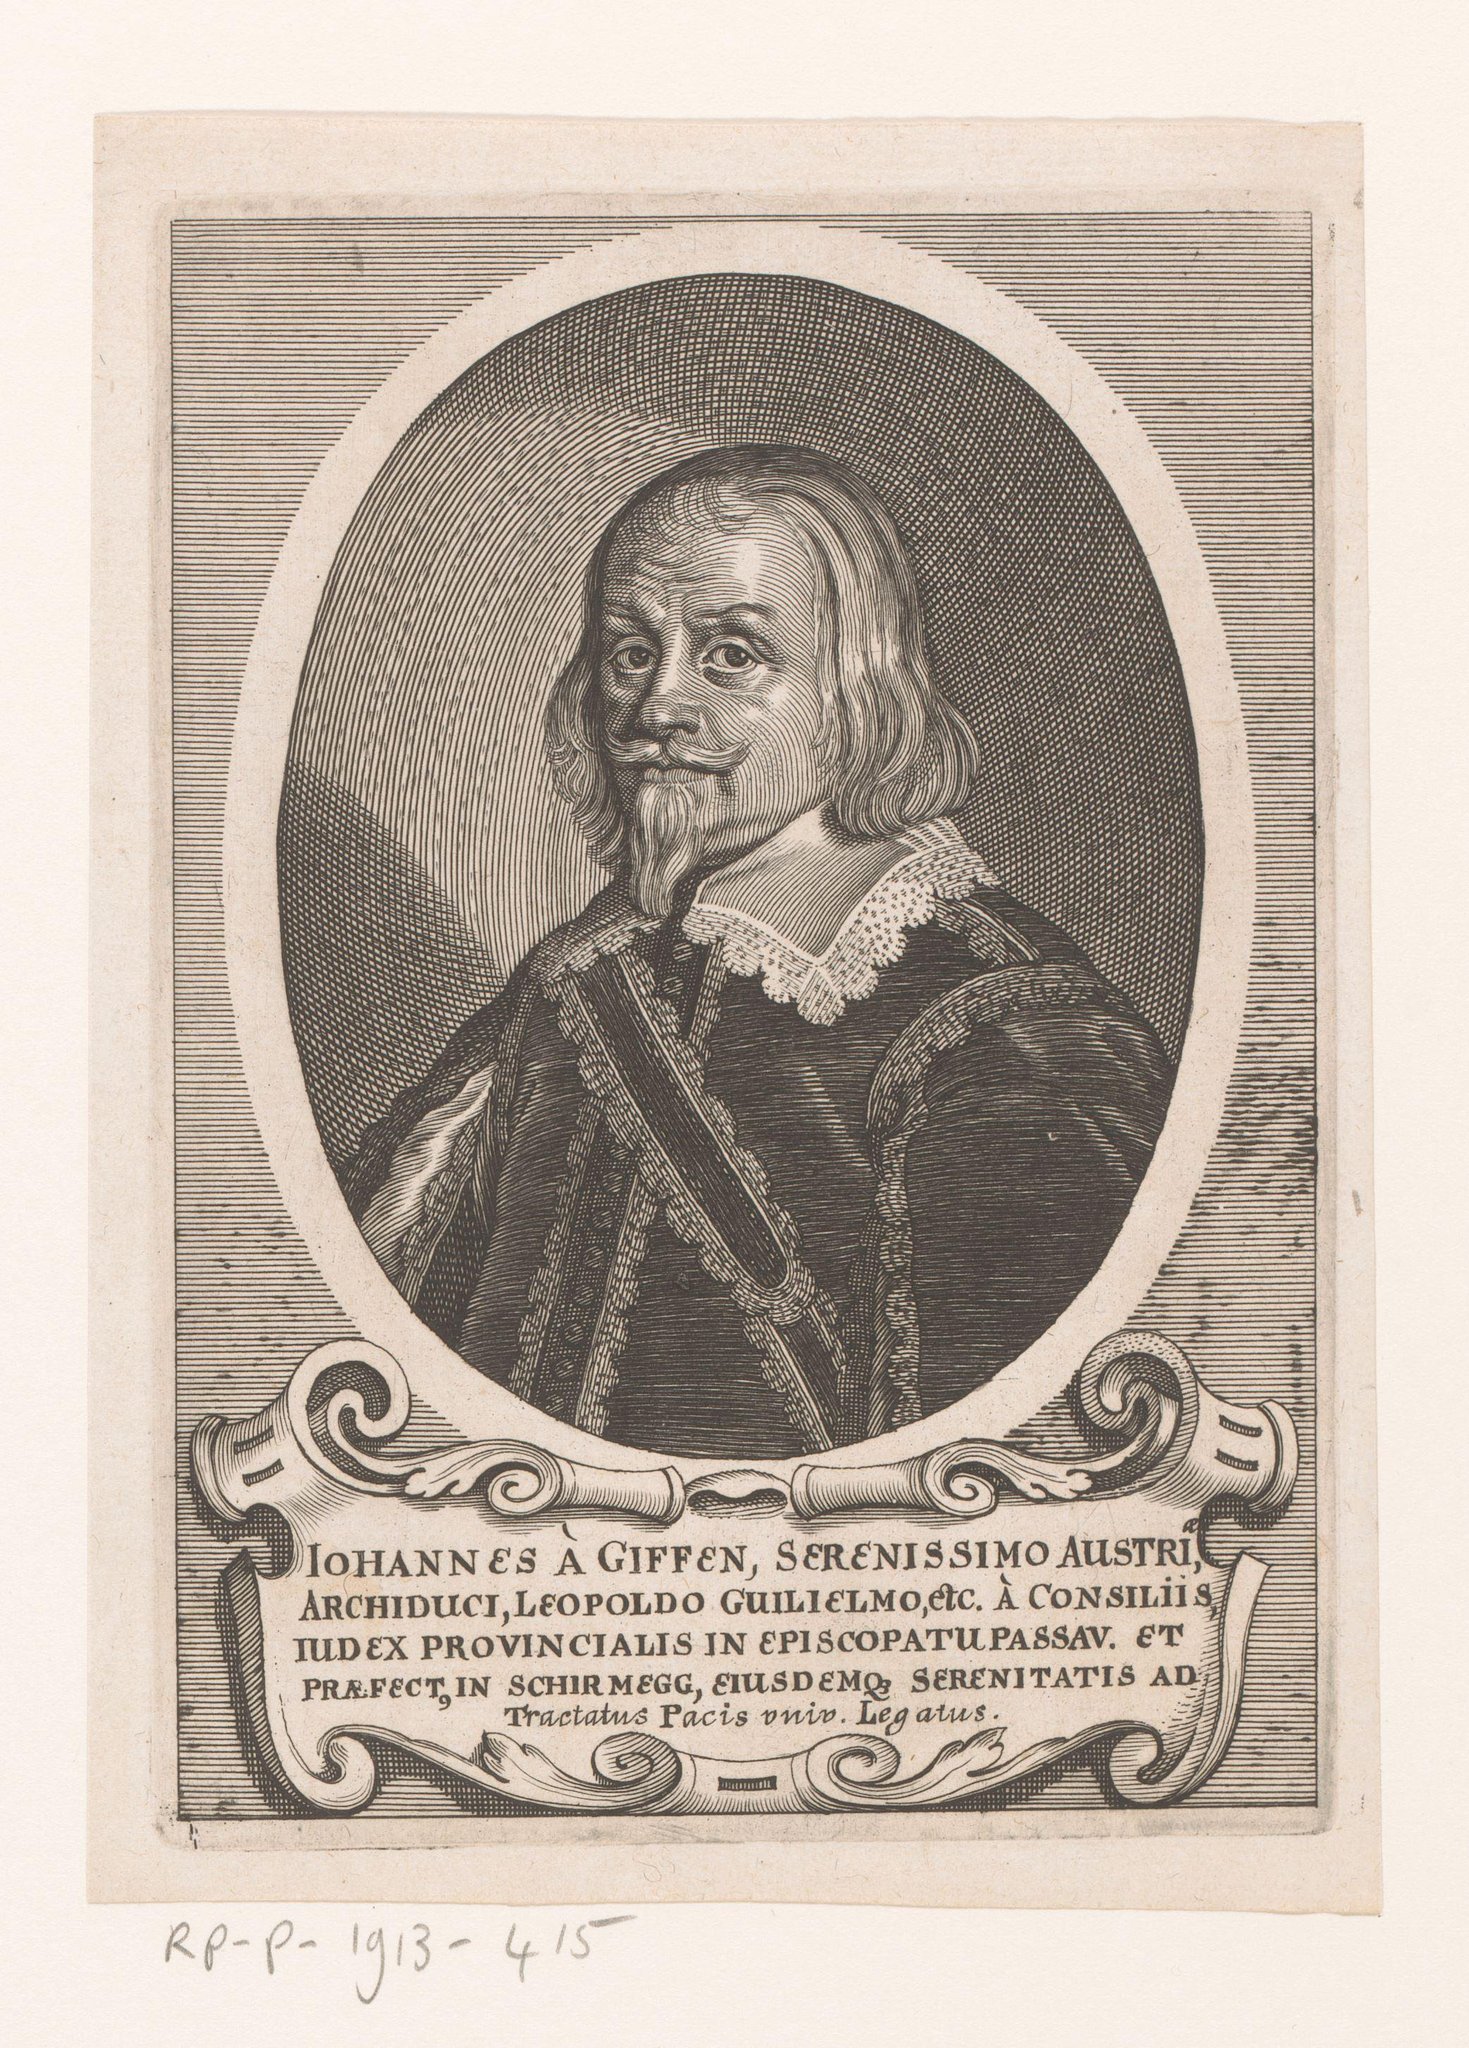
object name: book illustration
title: Portret van Johann van Giffen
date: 1652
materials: paper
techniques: engraving, etching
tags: historical persons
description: Illustratie in: J.G. Schleder. Theatrum Europaeum. Dl. 6. Frankfurt a.M., Merian, 1652. P. 921.